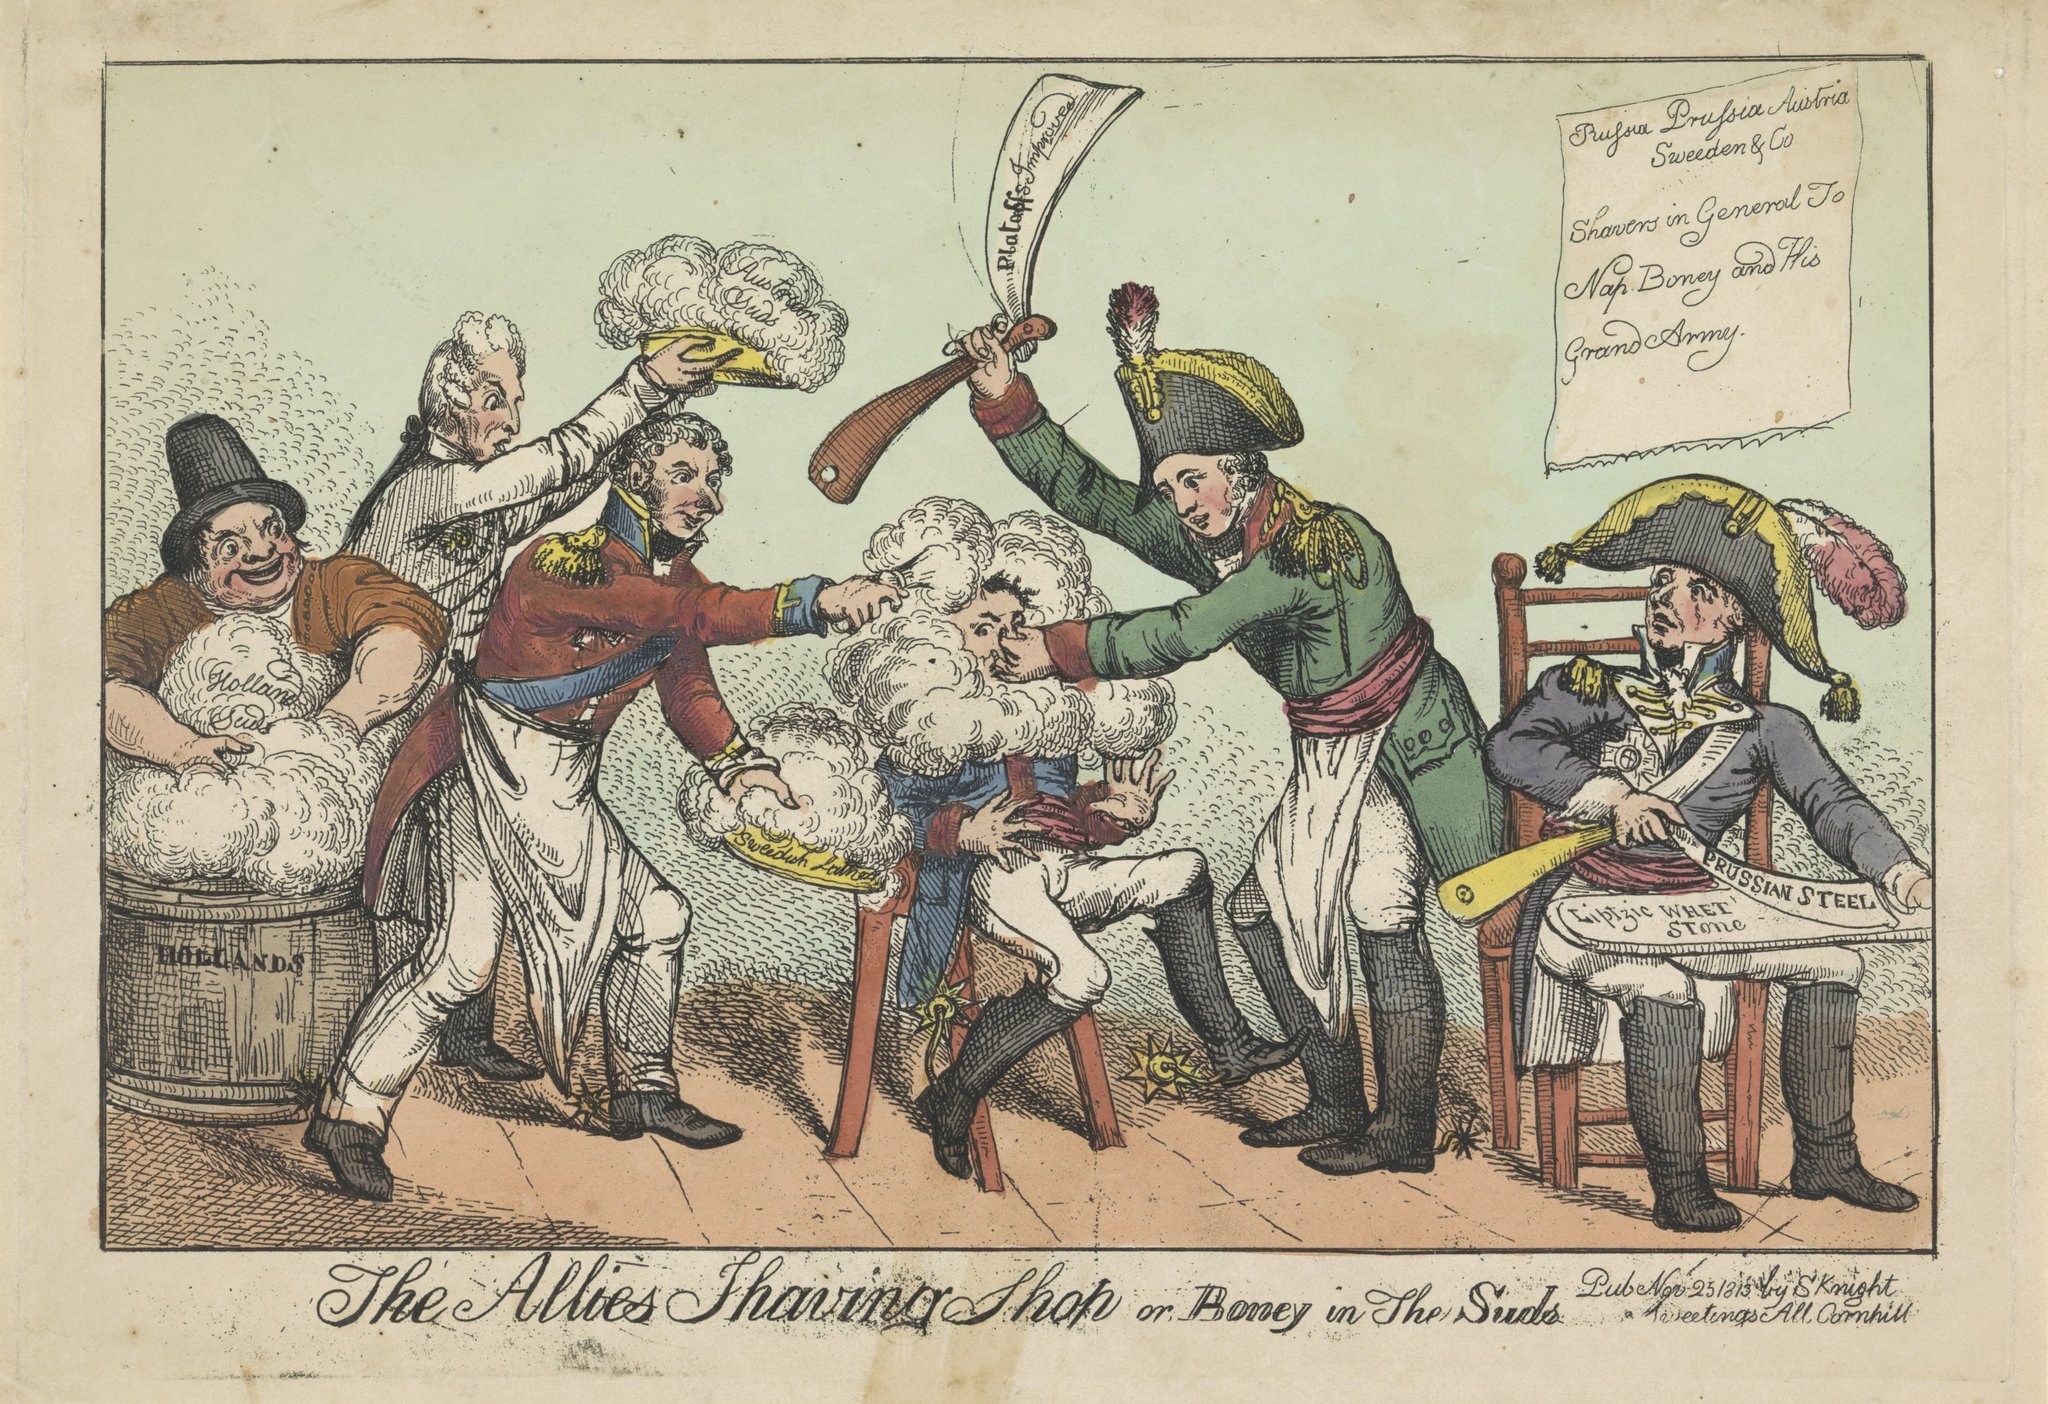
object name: cartoon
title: Napoleon wordt geschoren, 1813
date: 1813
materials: paper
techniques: etching, hand coloring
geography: london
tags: vienna, frans ii (rooms-duits keizer), napoleon i (emperor of the french), alexander i (tsaar van rusland), berlin, frederik willem iii koning van pruisen, shaving, being shaved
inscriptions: collector's mark: Lugt 2228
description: Spotprent op Napoleon na zijn verlies in de slag bij Leipzig, 1813. Napoleon zittend op een stoel wordt door de bondgenoten geschoren. Rechts de Russische tsaar Alexander I die de neus van Napoleon dichtknijpt en klaar staat om hem te scheren met een groot scheermes. Rechts slijpt de koning van Pruisen een volgend mes van Pruisisch staal. Links wordt schuim gemaakt en aangedragen door kroonprins Bernadotte van Zweden, de keizer van Oostenrijk en een Hollander.